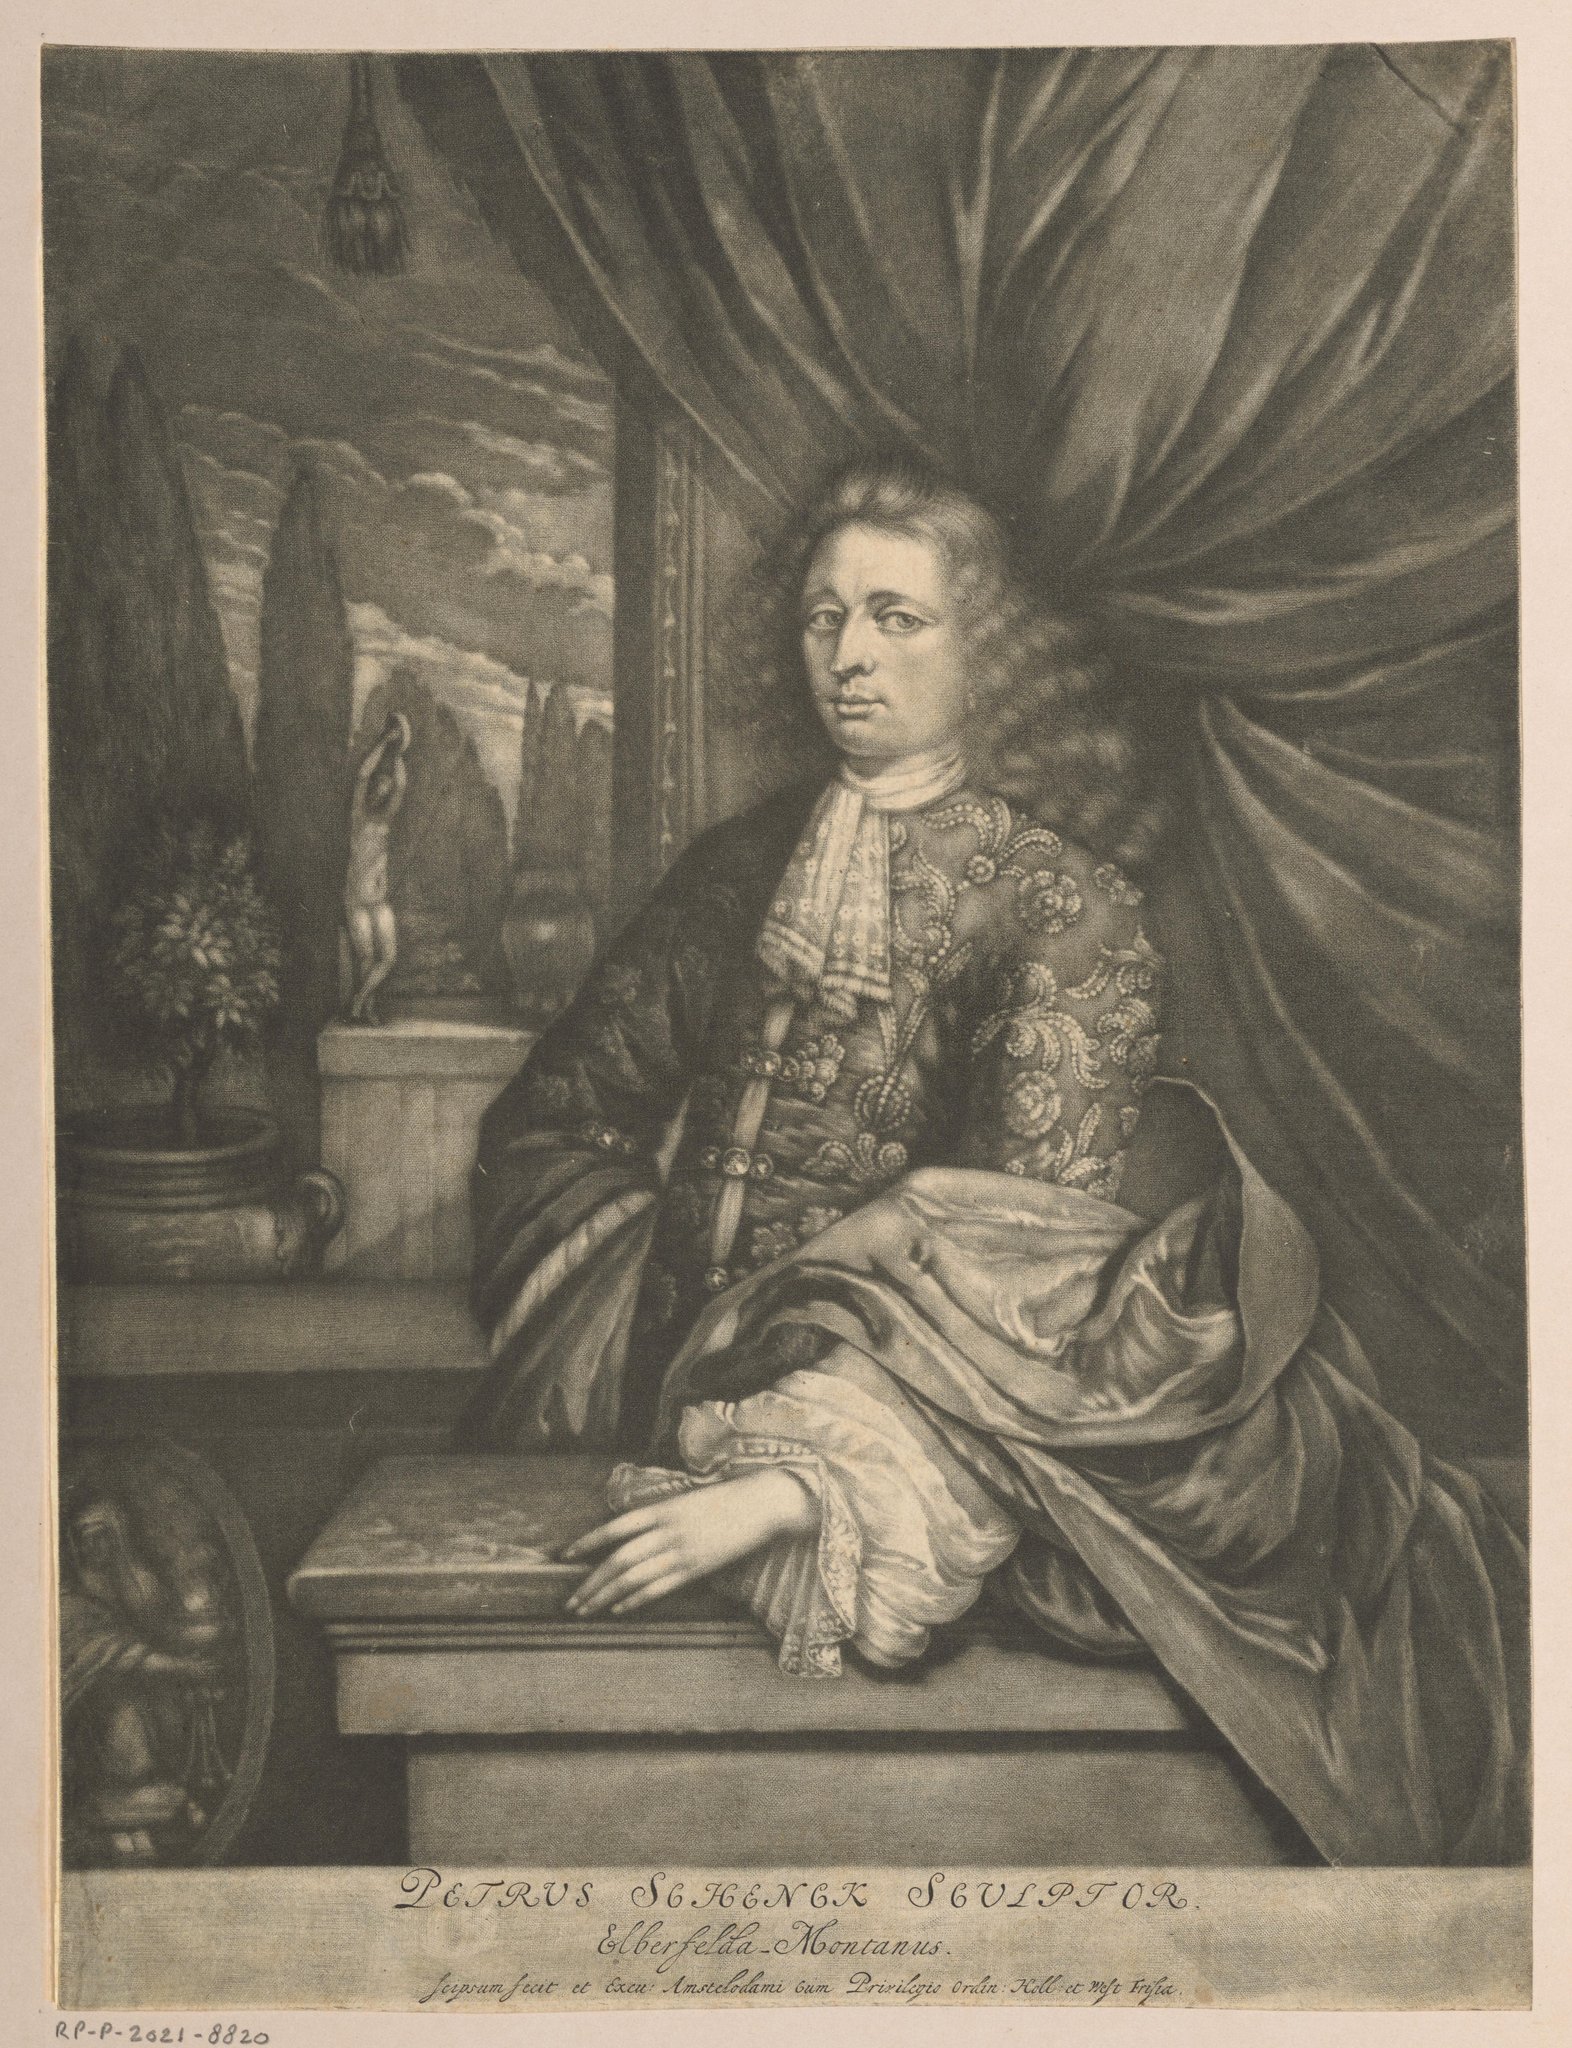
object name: print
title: Zelfportret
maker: pieter schenk (i)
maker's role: print maker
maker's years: 1660-1711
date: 1675-1711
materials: paper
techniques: engraving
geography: amsterdam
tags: print maker, pieter schenk (i), historical persons, portrait, self-portrait of painter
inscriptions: collector's mark: Lugt 2228